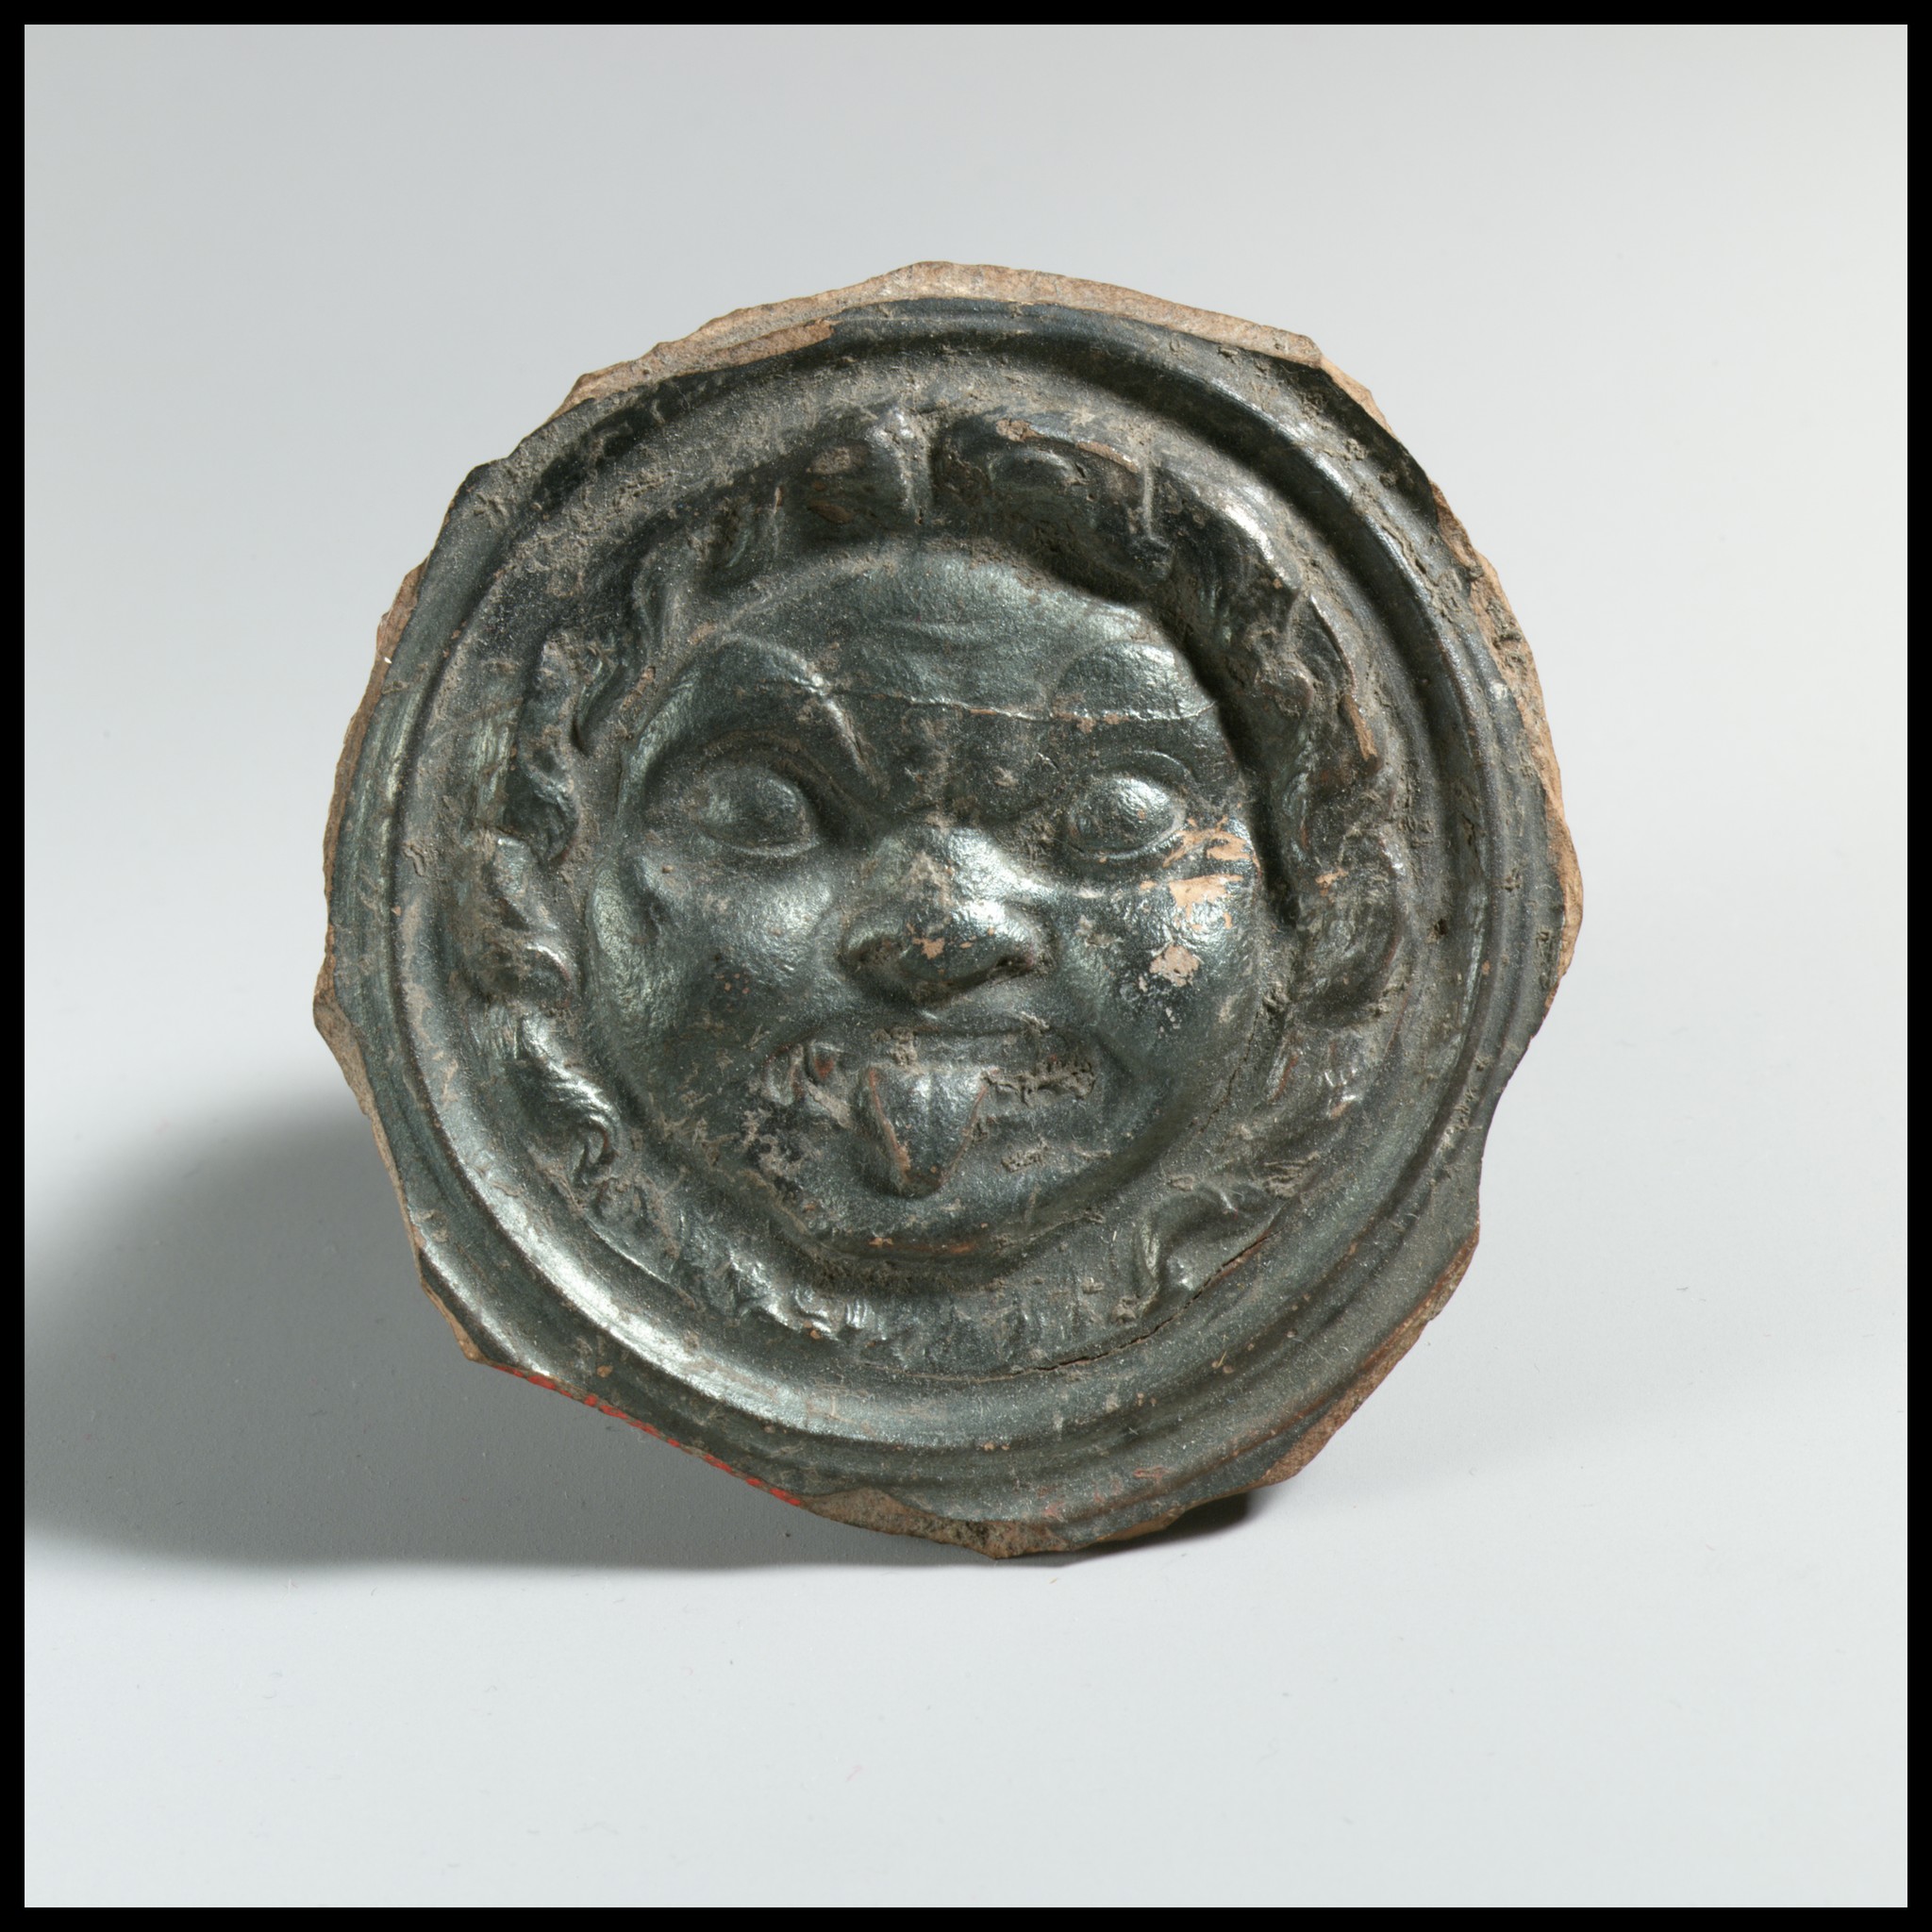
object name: phiale, fragmentary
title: Terracotta tondo from a phiale (libation bowl)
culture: greek, calenian or campanian or south italian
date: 300-201 BCE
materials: terracotta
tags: gorgons